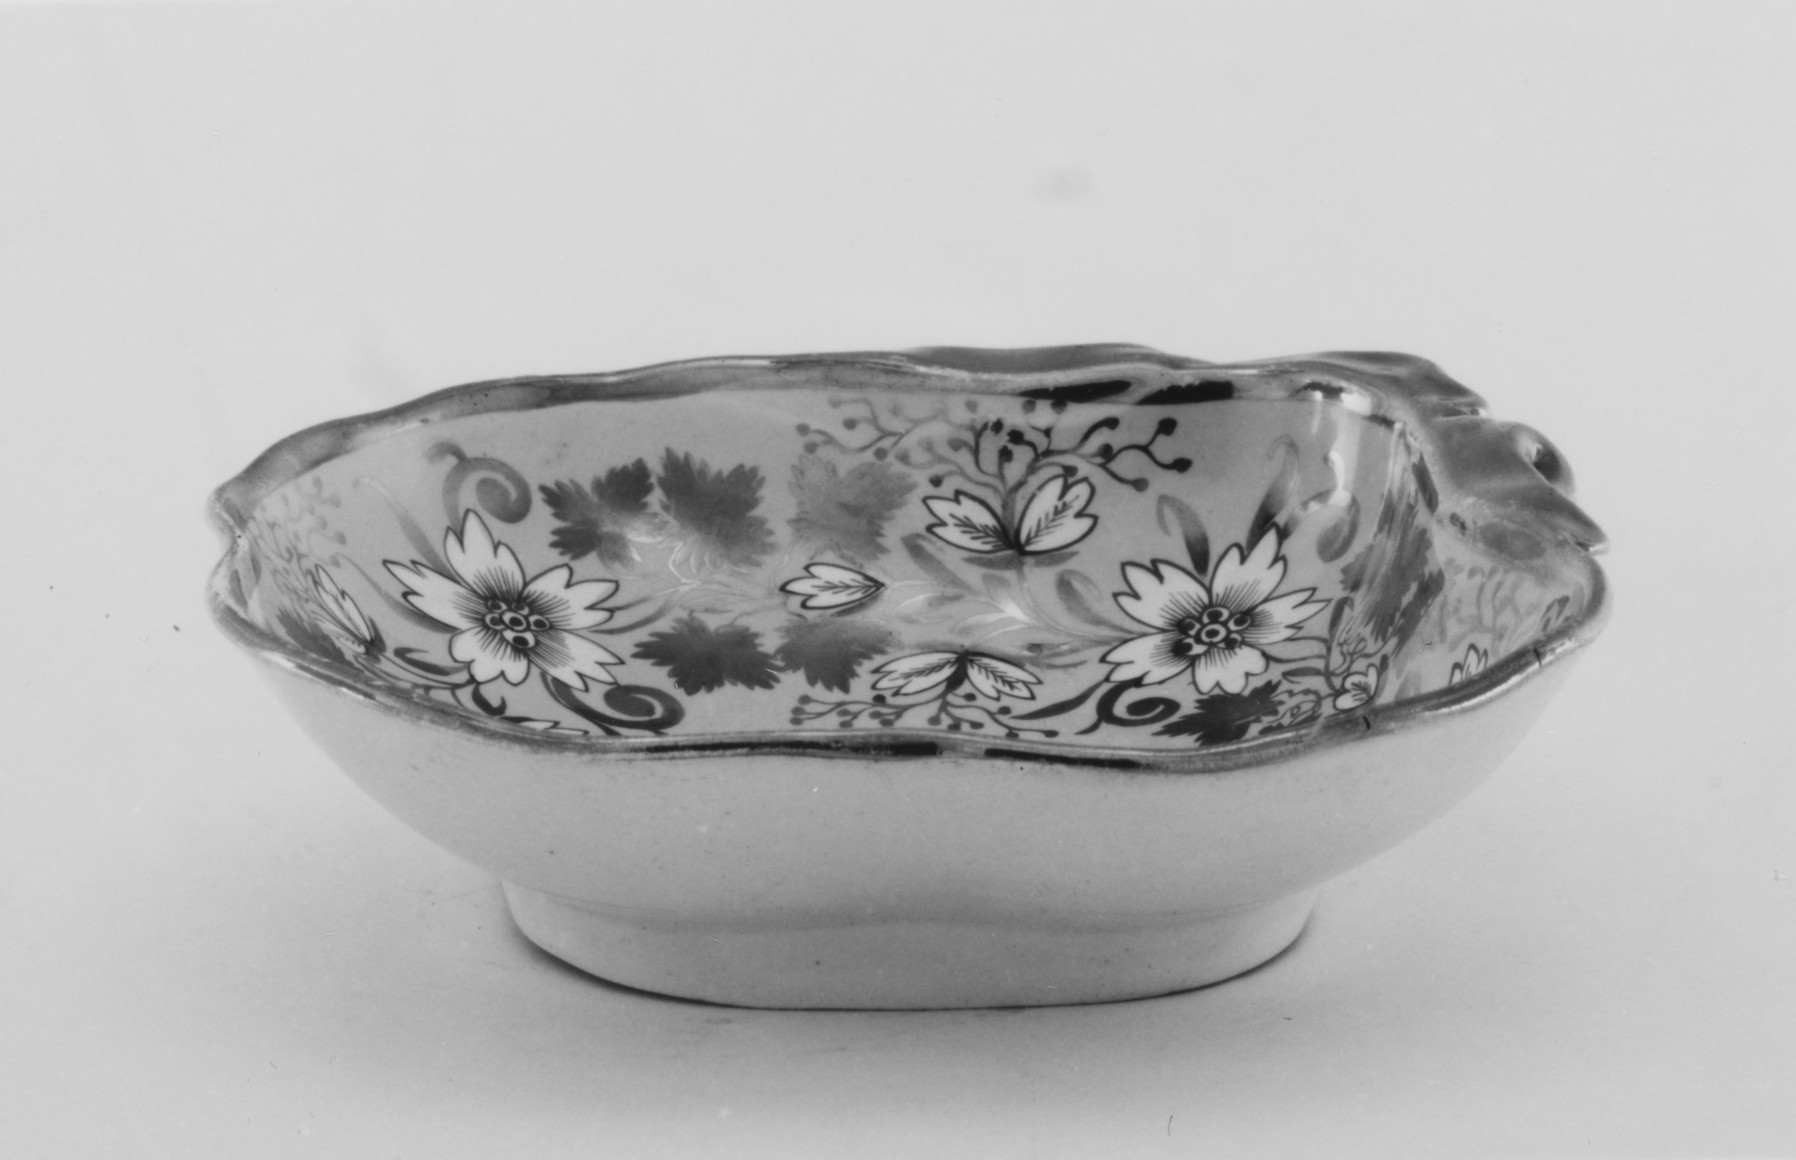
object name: dish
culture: british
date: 1835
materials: earthenware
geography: england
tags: flowers